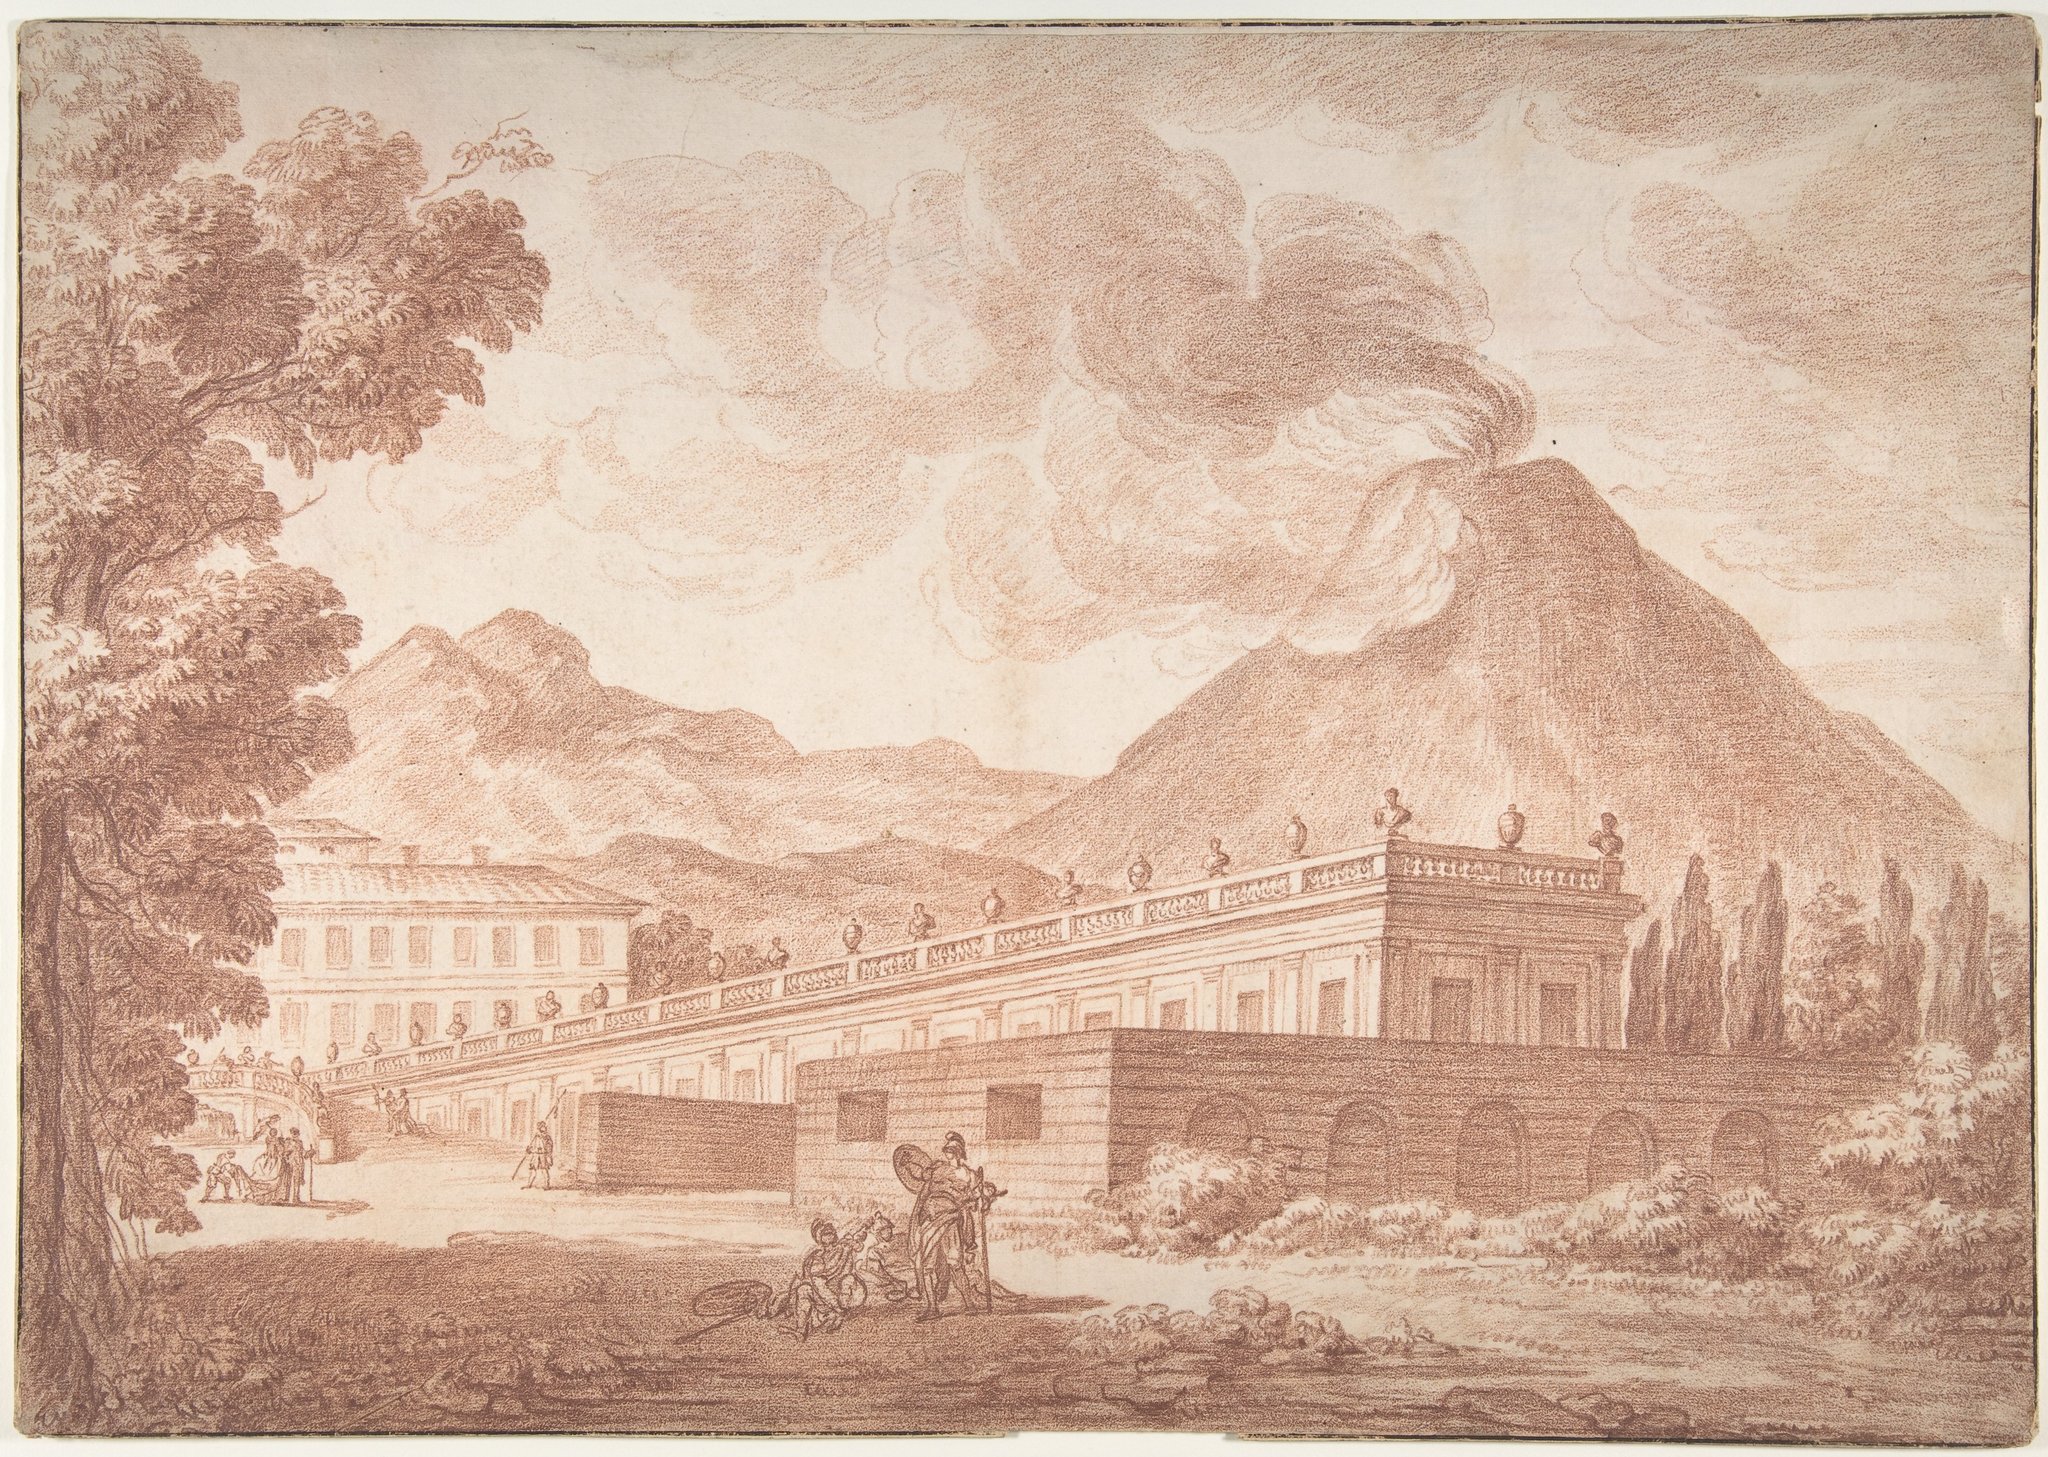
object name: drawing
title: The Palazzo Reale at Pórtici with Vesuvius in the Background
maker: louis chaix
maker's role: artist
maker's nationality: french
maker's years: 1740-1811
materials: chalk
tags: palaces,volcanoes